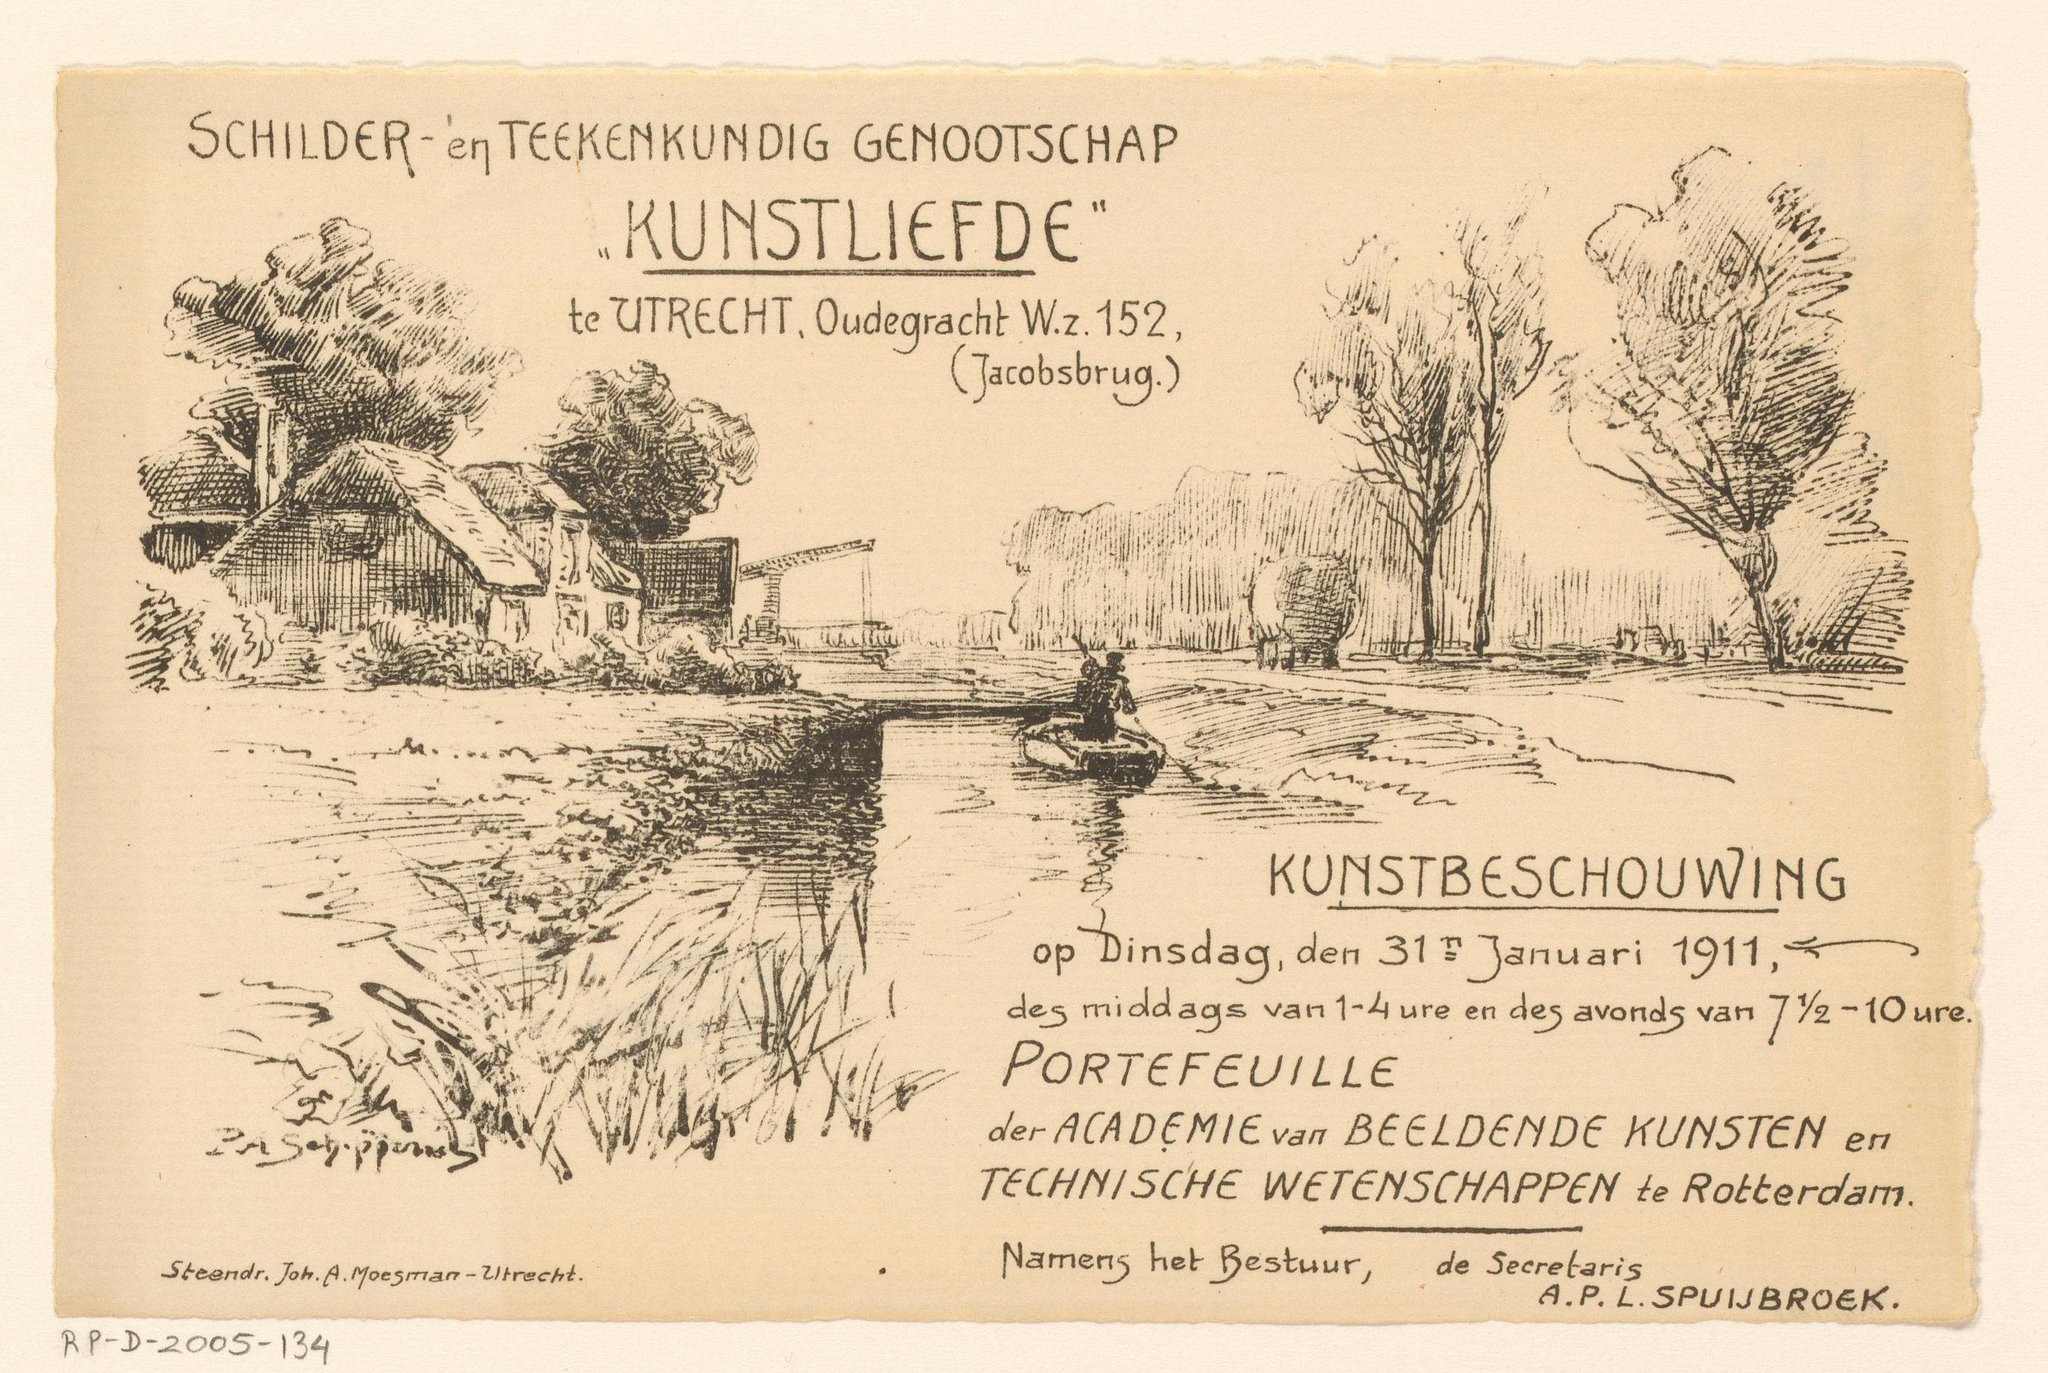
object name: invitation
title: Uitnodiging van Schilder- en Teekenkundig Genootschap "Kunstliefde" voor een kunstbeschouwing, 31 januari 1911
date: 1901-1911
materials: paper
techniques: lithograph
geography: utrecht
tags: criticizing and discussing art, art criticism, circle, club of artists, collecting and exhibiting products of the fine arts, water course, farm or solitary house in landscape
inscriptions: collector's mark: Lugt 2228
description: Landschap met sloot en boerderij. Uitnodiging van Schilder- en Teekenkundig Genootschap "Kunstliefde" voor een kunstbeschouwing op 31 januari 1911 van de portefeuille van de Academie van Beeldende Kunsten en Technische wetenschappen te Rotterdam.